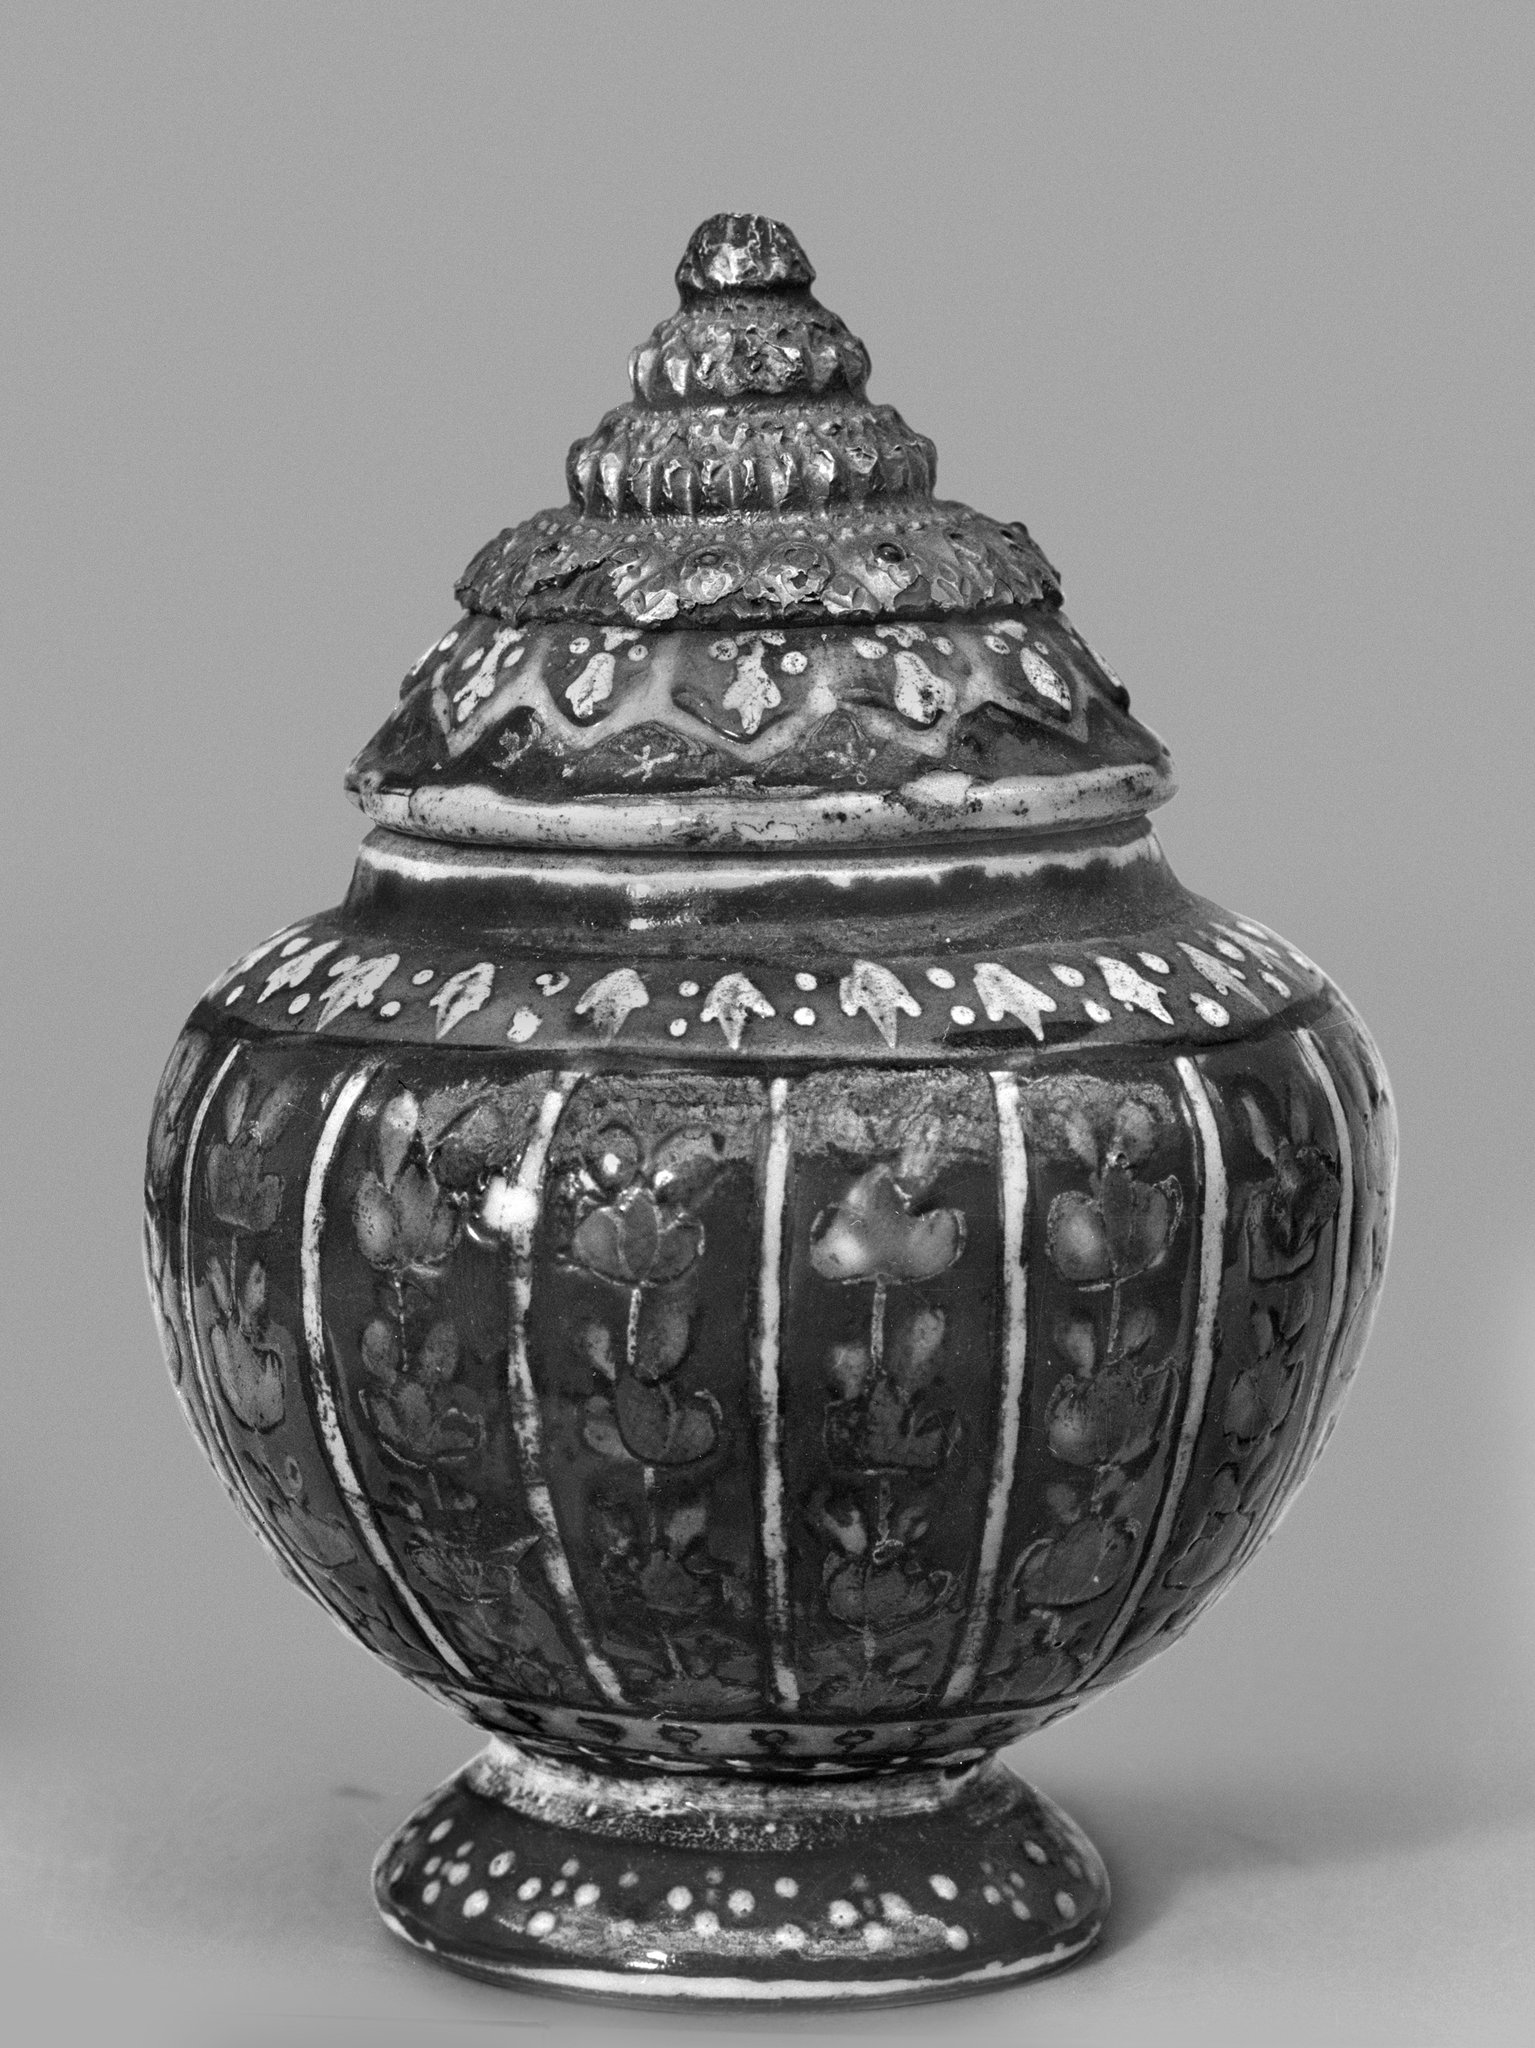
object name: covered bowl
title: Covered bowl with floral pattern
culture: chinese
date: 1801-1900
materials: enamel, porcelain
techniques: overglaze, painting, polychrome